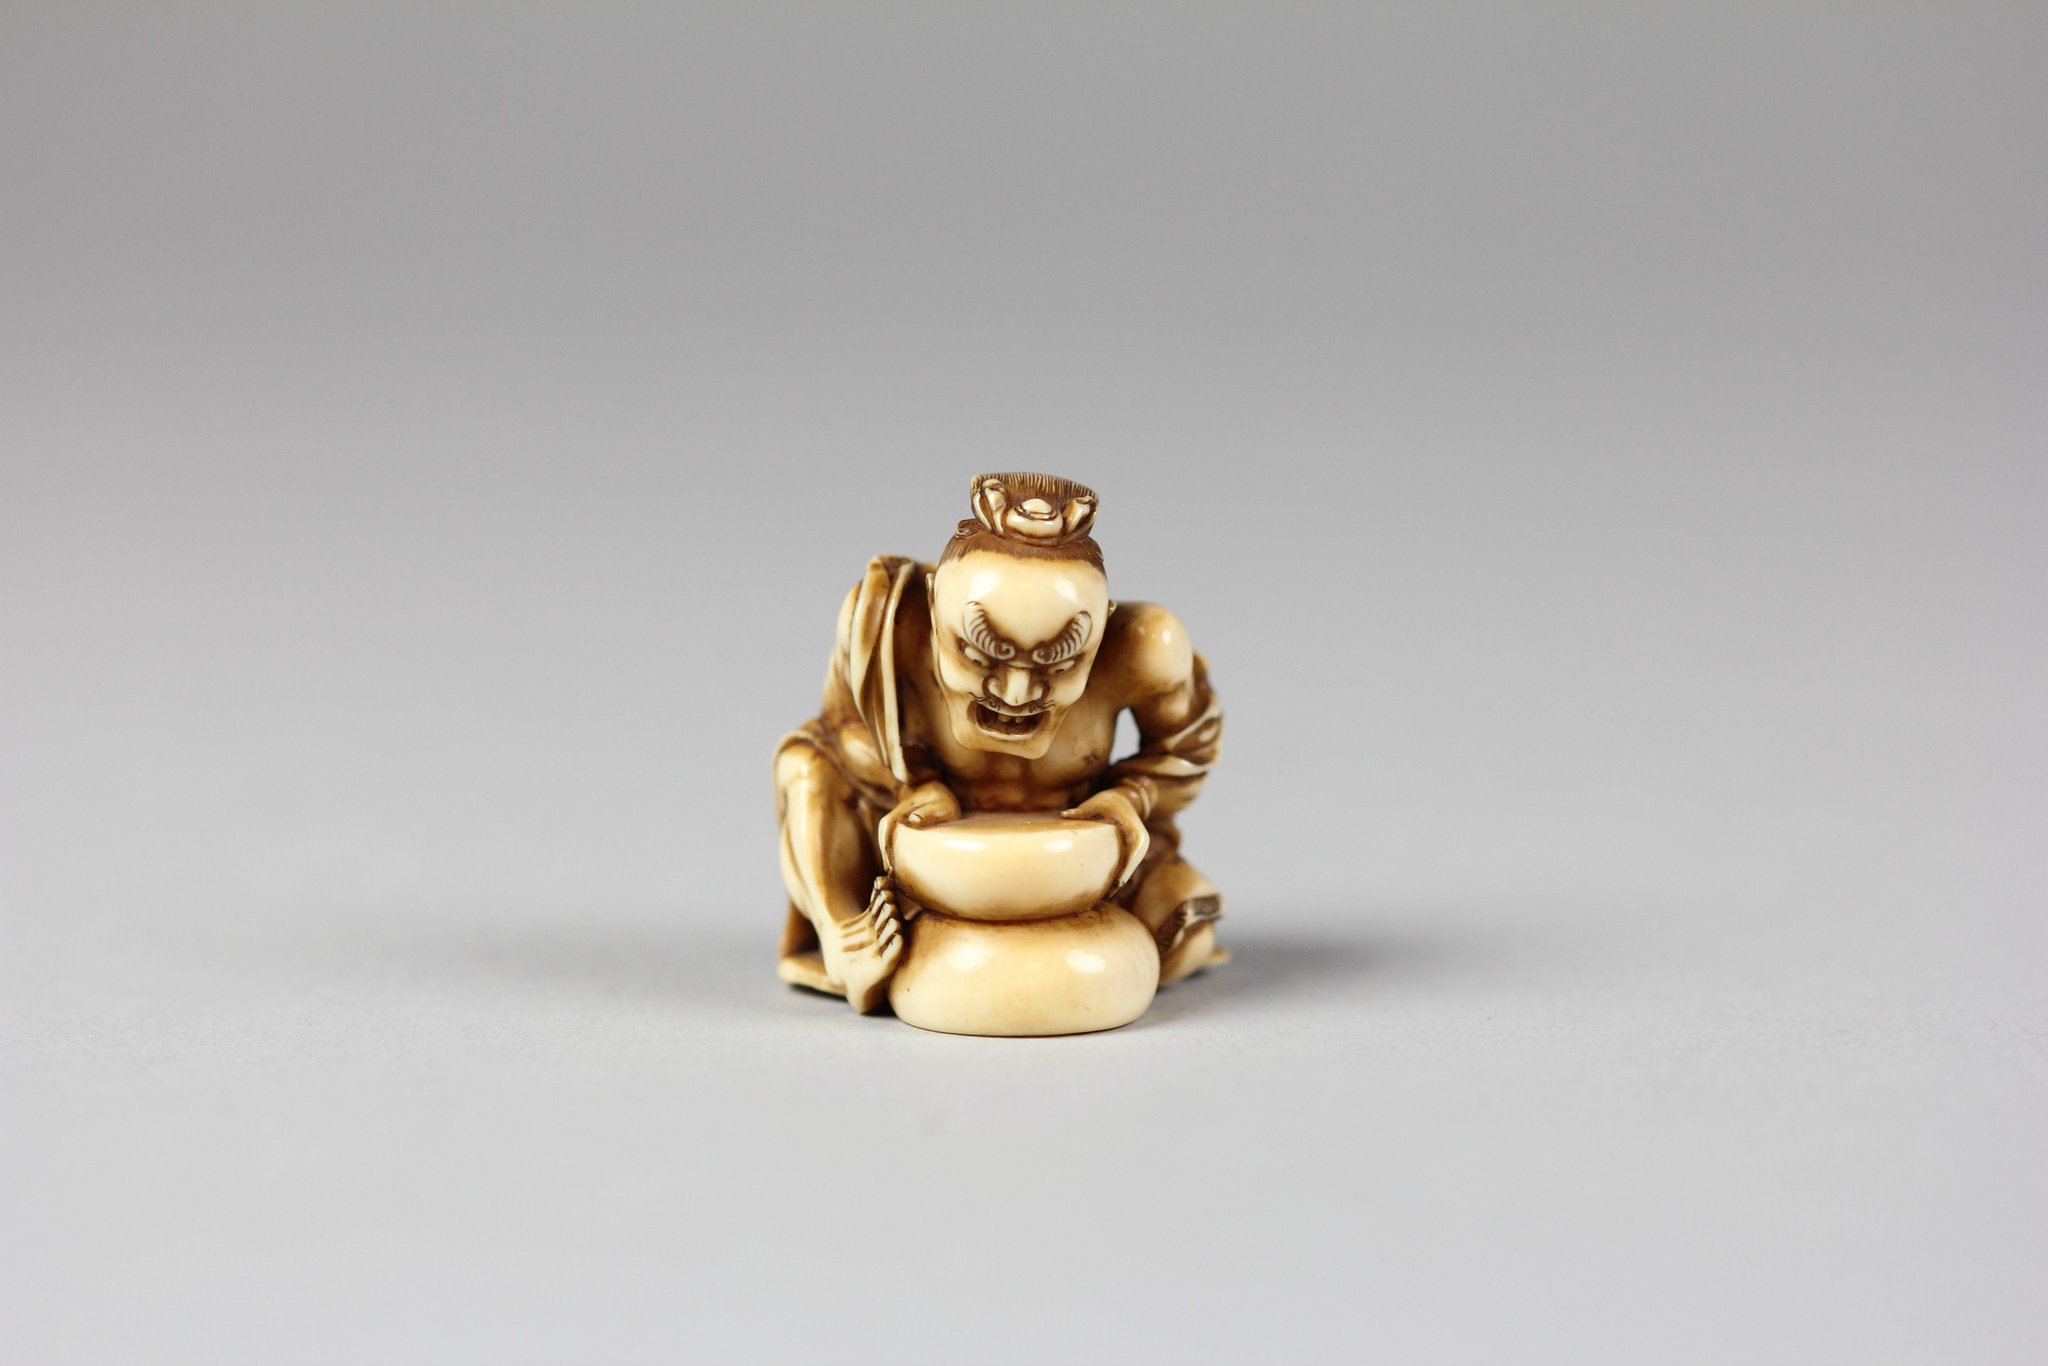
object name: netsuke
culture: japanese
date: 1801-1900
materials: ivory